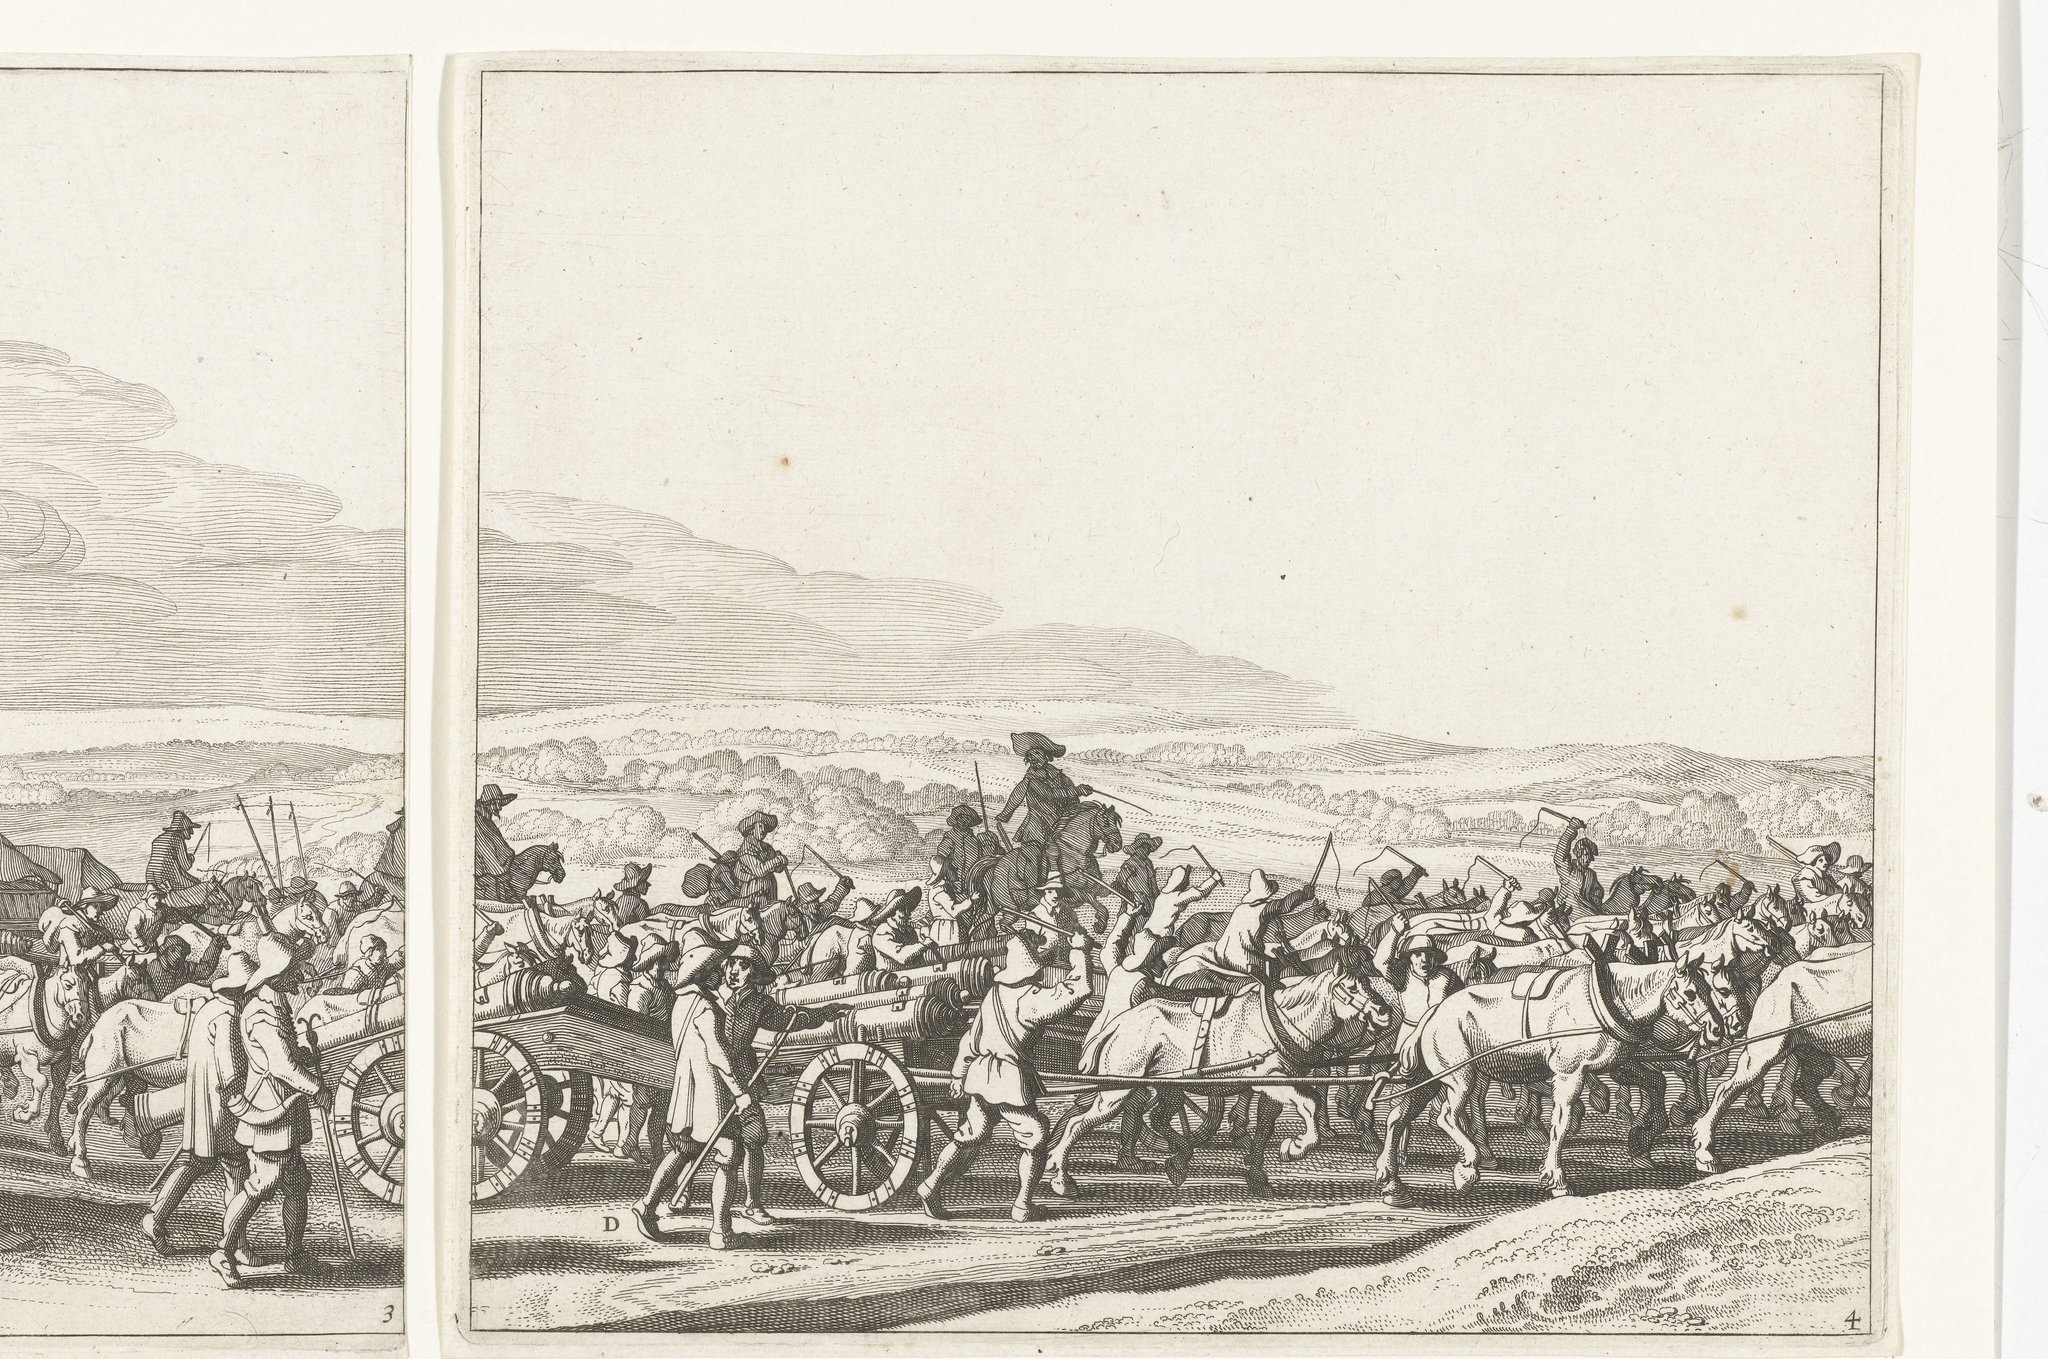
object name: print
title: Discessus Hispanici Praesidii Trajecti ad Mosam Ao. 1632. Die 23 Augusti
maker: jan van de velde (ii)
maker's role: draughtsman, painter, print maker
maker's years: 1593-1641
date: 1633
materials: paper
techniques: etching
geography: northern netherlands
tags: the hague, frederick henry (prince of orange), retreat of the defeated, maastricht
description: Uittocht van het Spaanse leger uit Maastricht, 23 augustus 1632. Fries van zes genummerd platen, plaat nr. 4. De artillerie van het vertrekkende leger.